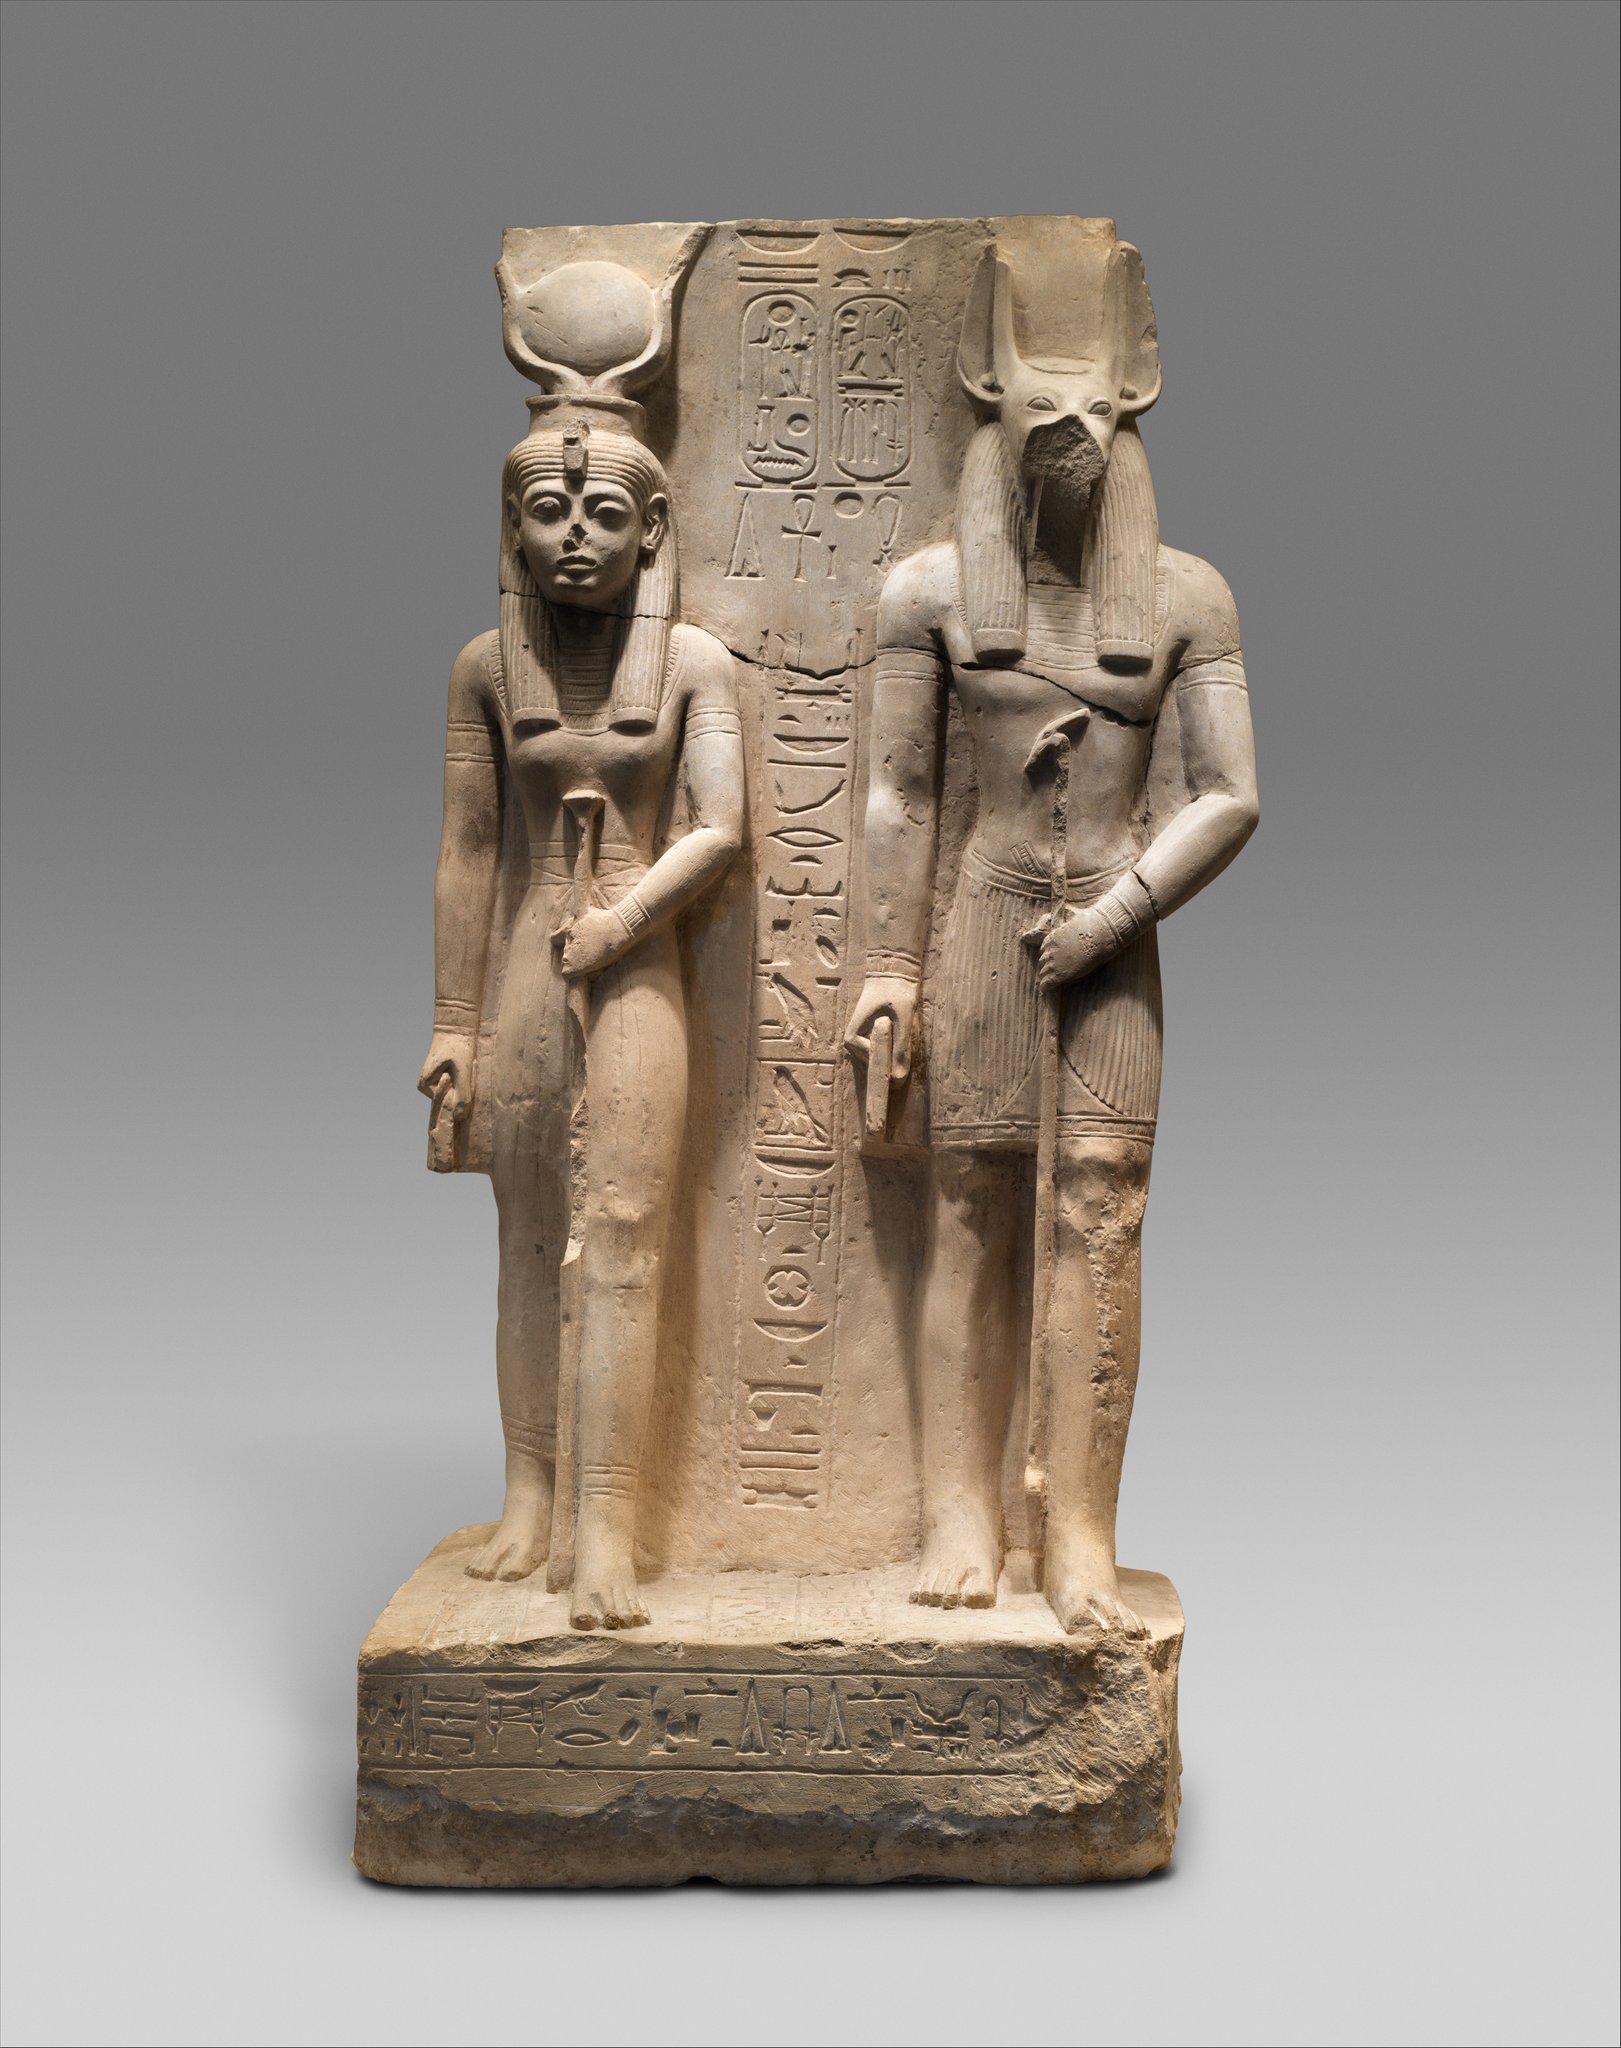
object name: statue, isi, wepwawet, dedicated by siese, ramesses ii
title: Statue of Wepwawet and Isis-Hathor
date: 1279-1213 BCE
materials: limestone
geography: middle egypt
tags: men,women,isis